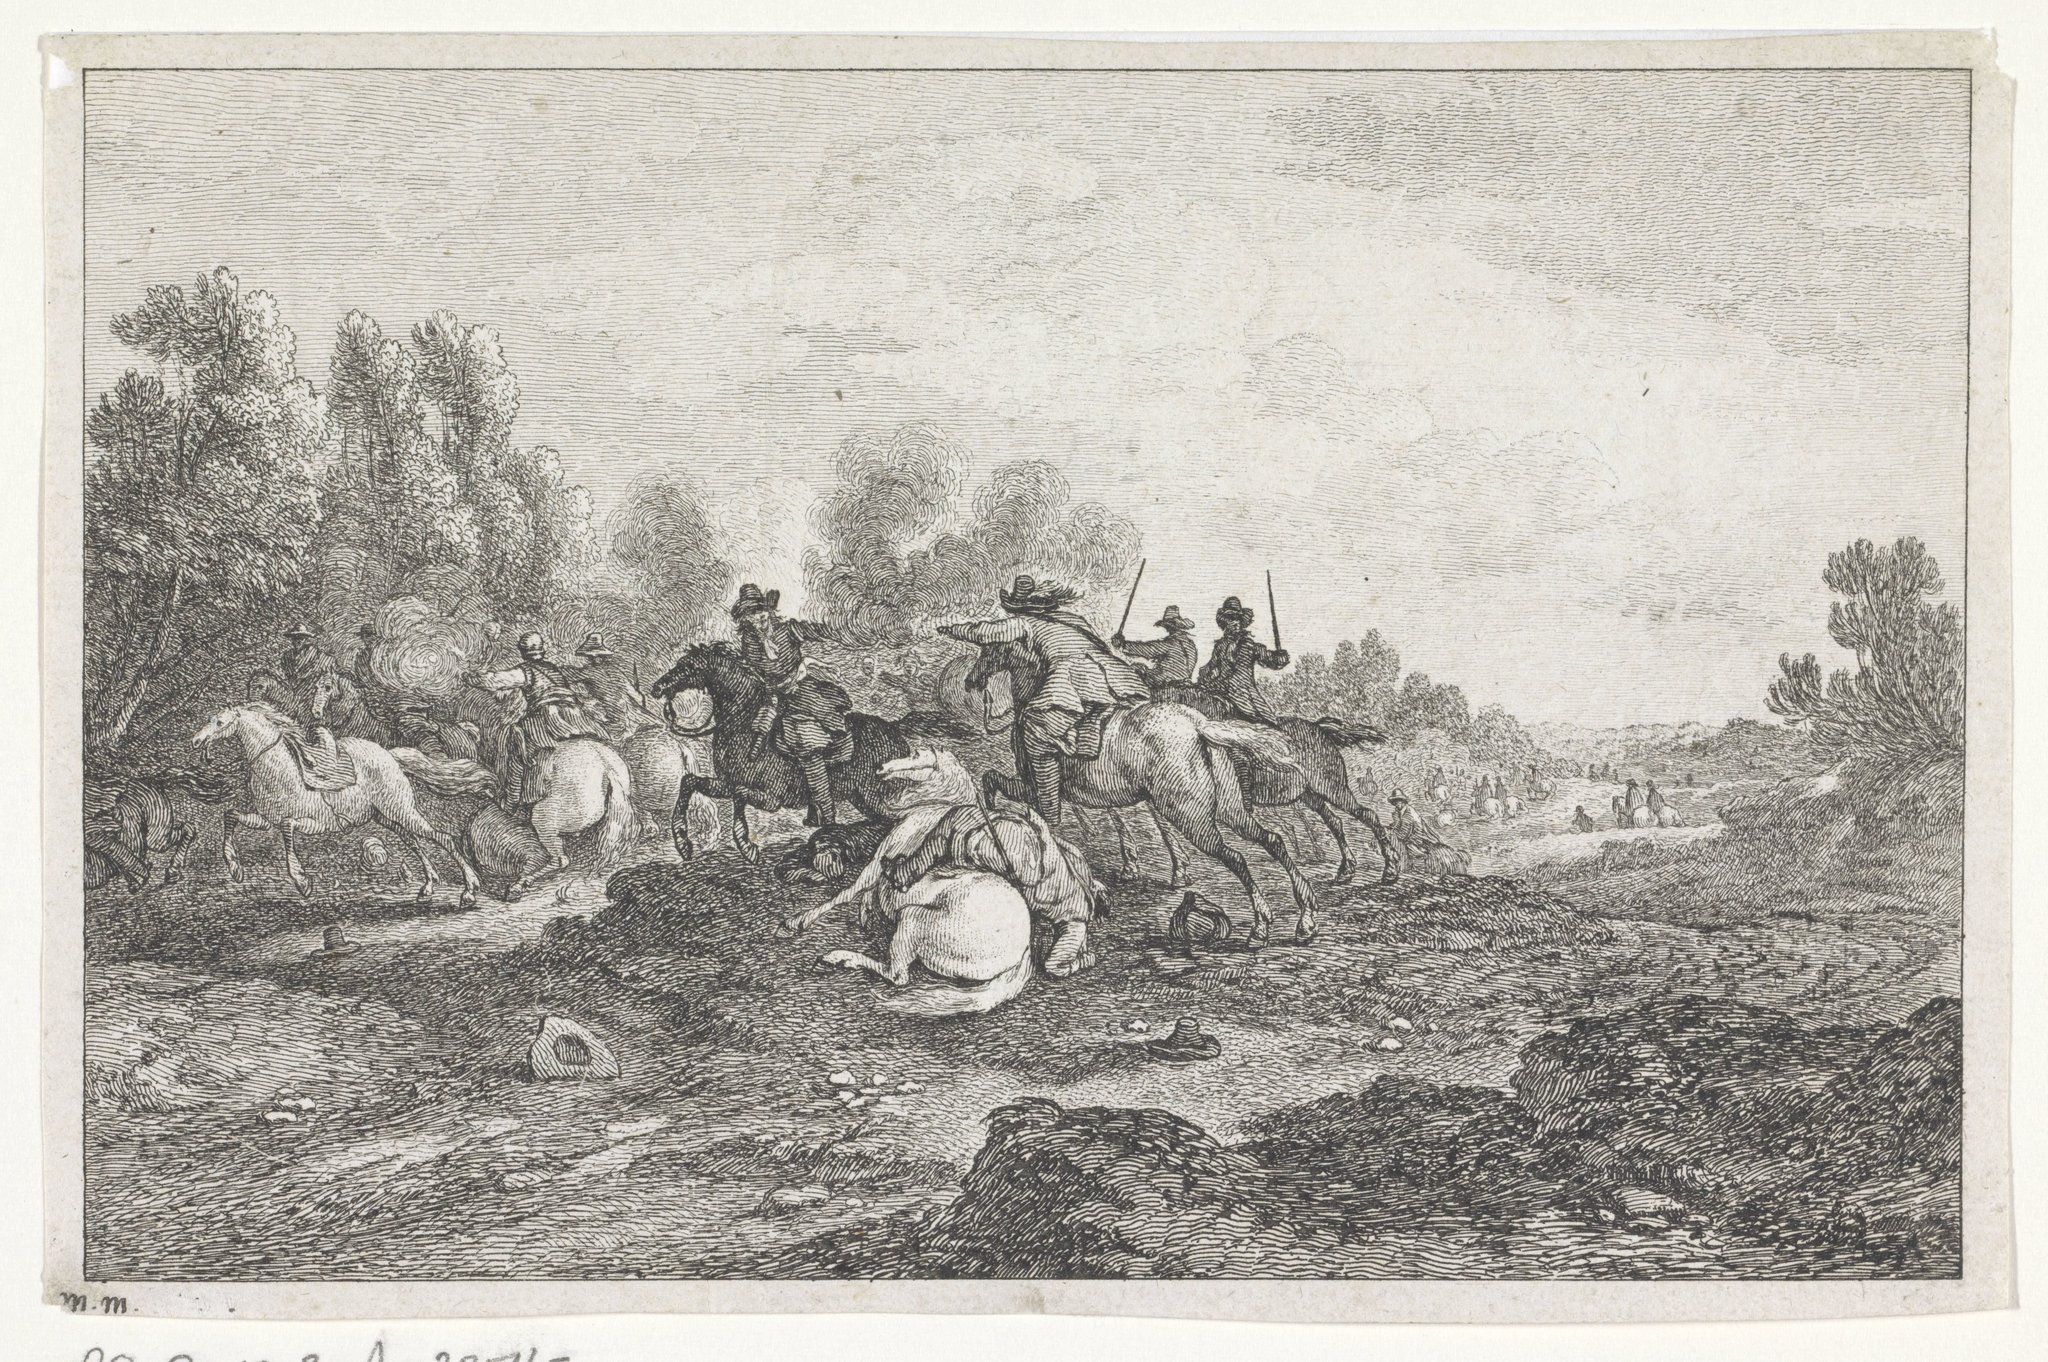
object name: print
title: Ruitergevecht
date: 1650-1750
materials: paper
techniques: etching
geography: netherlands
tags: riding a horse, ass, or mule; rider, horseman, battle, fighting in general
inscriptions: collector's mark: Lugt 2228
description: Een gevecht tussen ruiters op een weg. Op de voorgrond een gevallen paard. Linksonder gemerkt: M.M.